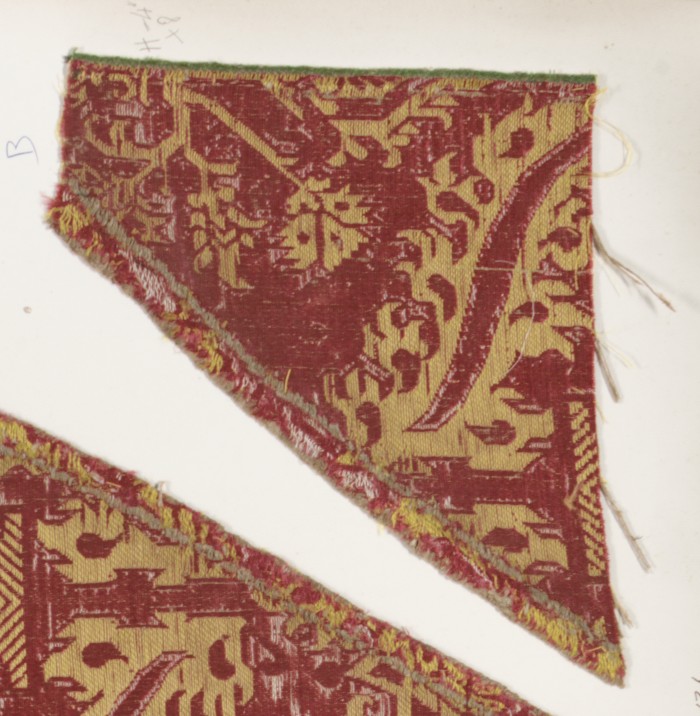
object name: fragment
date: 1601-1633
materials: silk